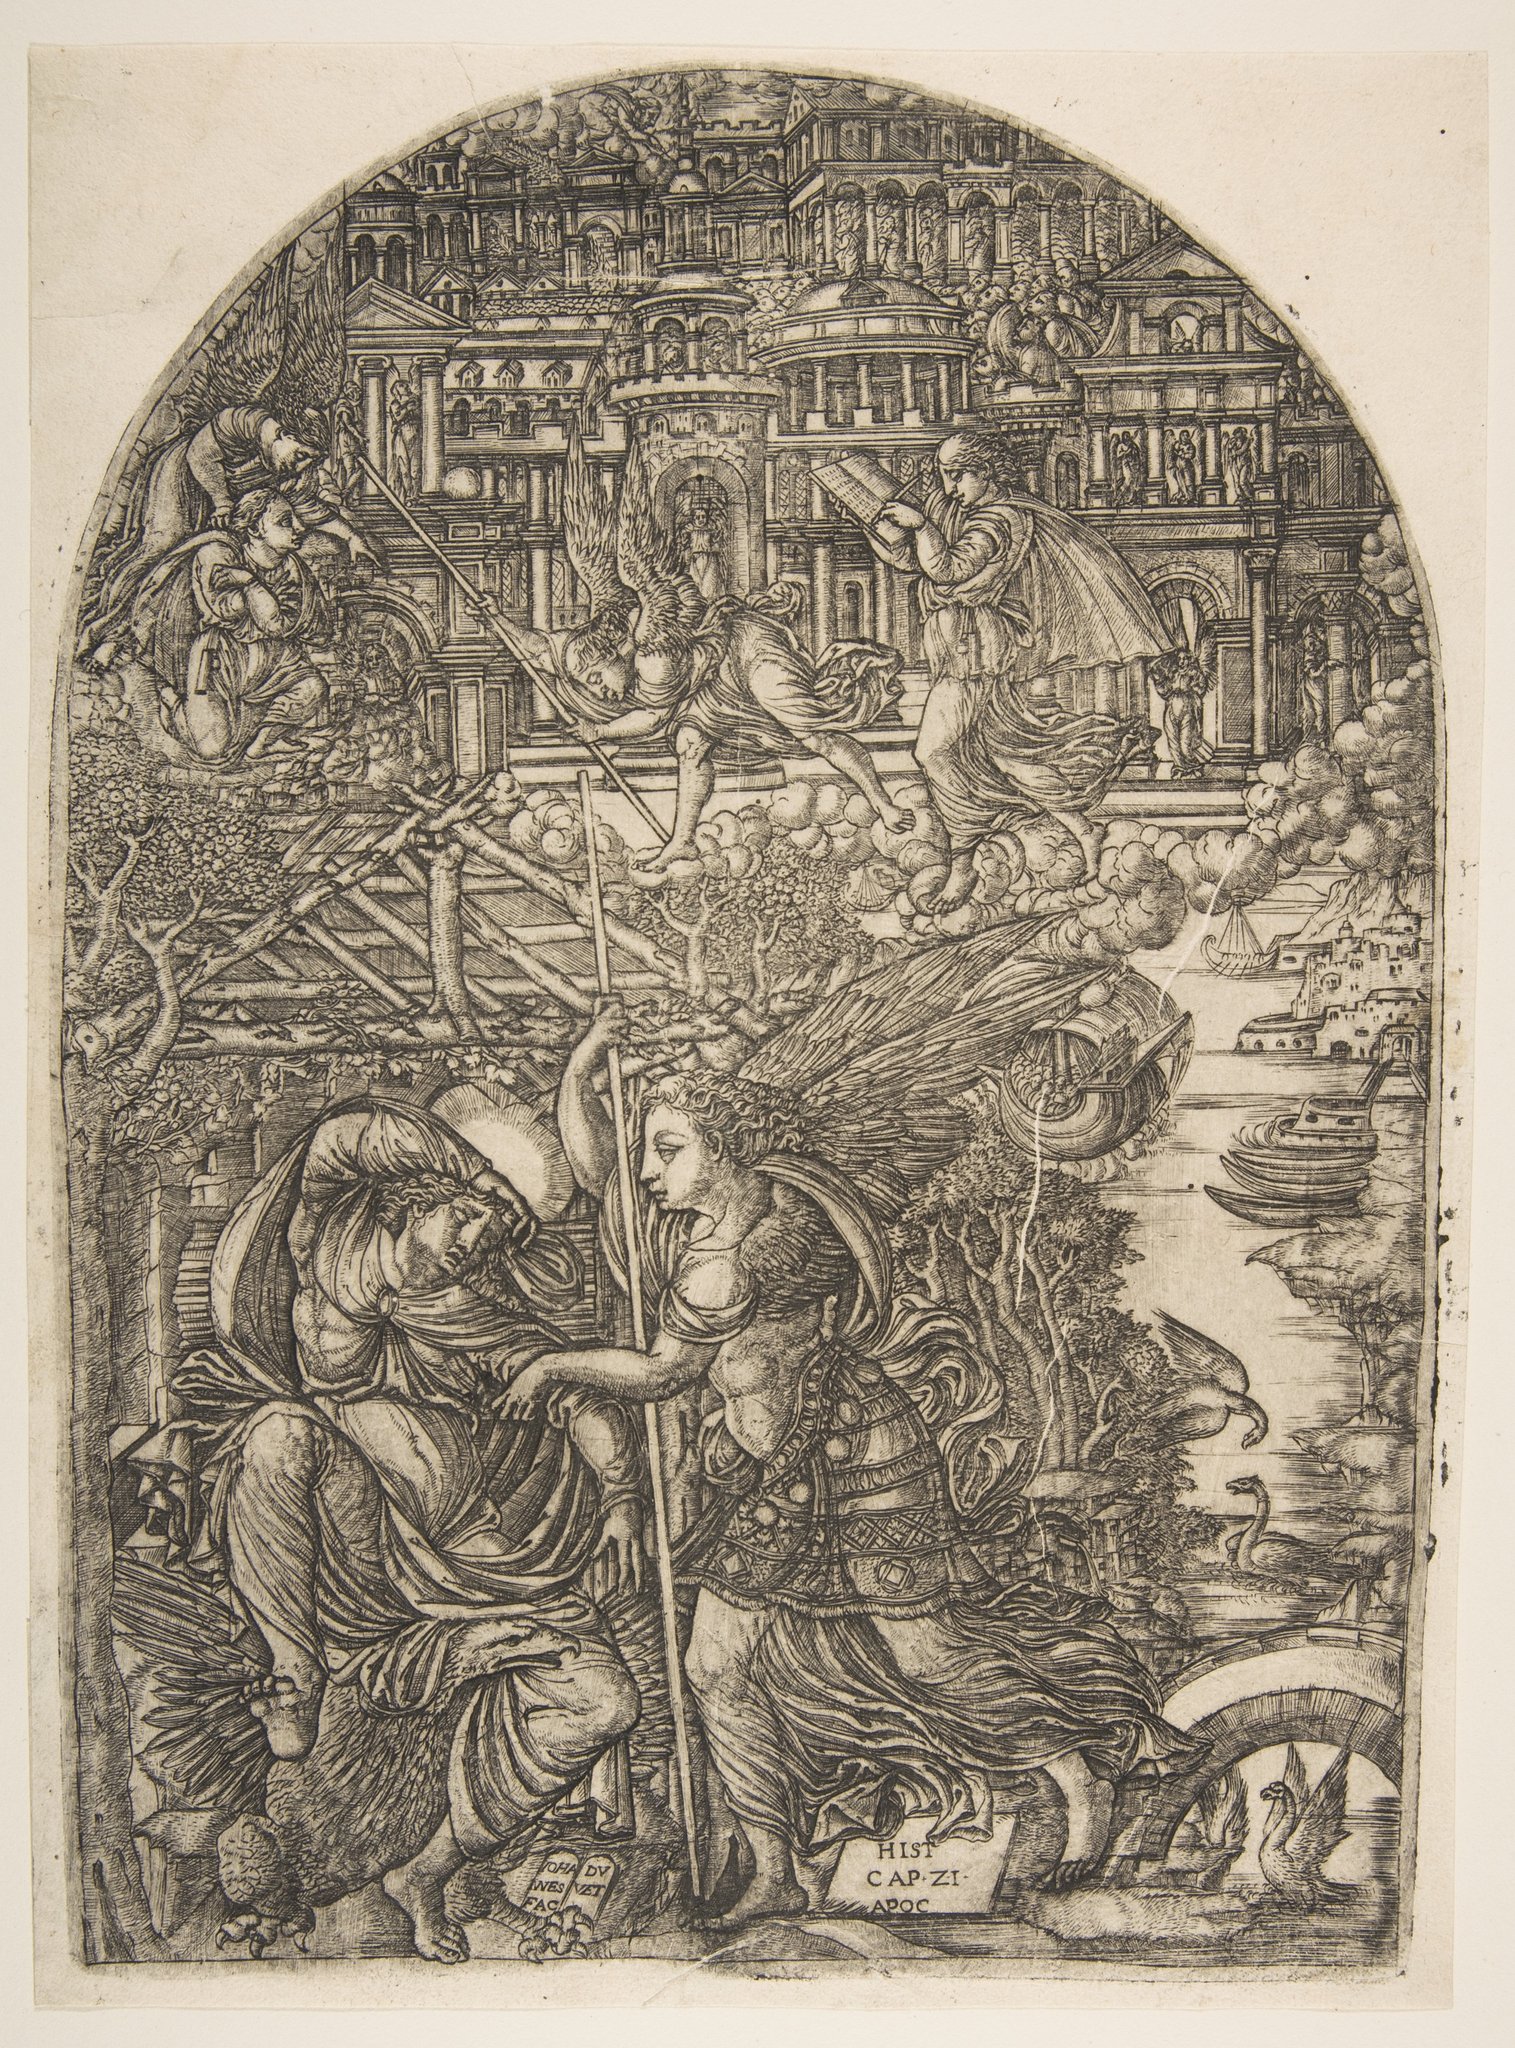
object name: print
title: The Angel shows Saint John the New Jerusalem, from the Apocalypse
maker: jean duvet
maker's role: artist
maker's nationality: french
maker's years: 1485-1561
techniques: engraving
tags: angels,saint john the baptist,apocalypse